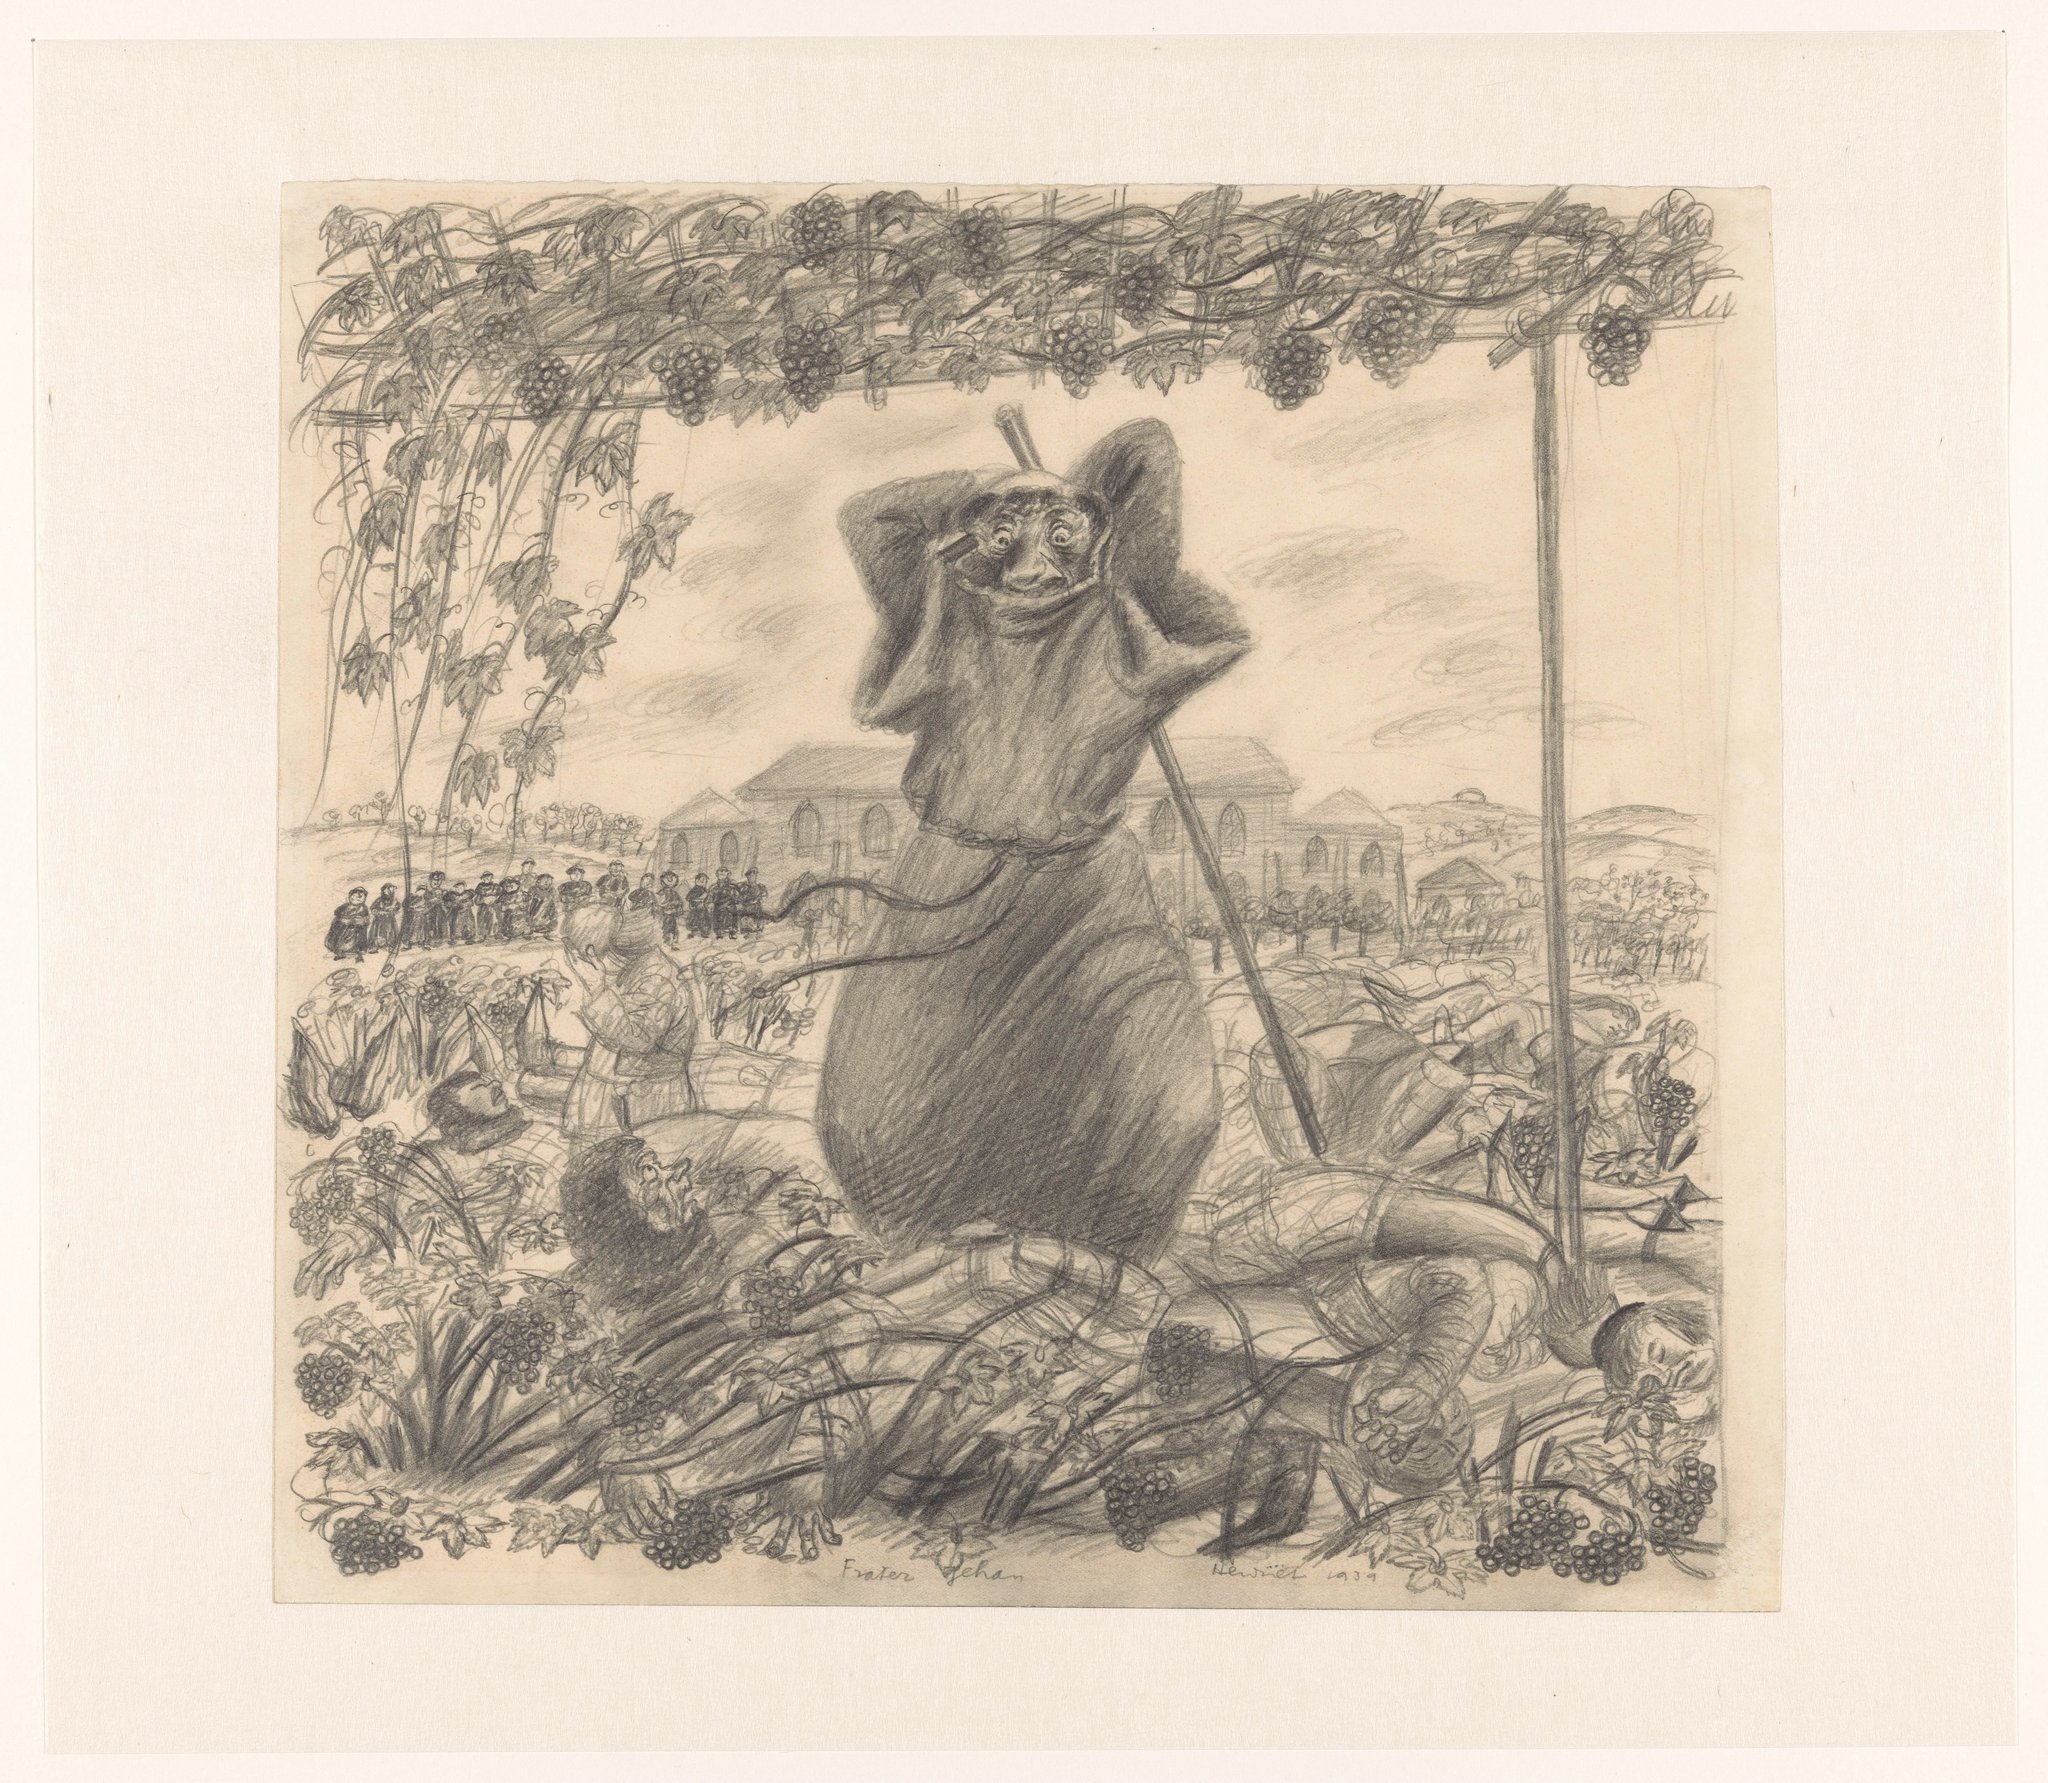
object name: drawing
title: Frater Johan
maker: henk henriët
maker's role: draughtsman, print maker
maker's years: 1903-1945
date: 1939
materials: paper, pencil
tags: vine, abbey, monastery, convent ~ roman catholic church, battle, monk(s), friar(s)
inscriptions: collector's mark: Lugt 2228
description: Monnik in een wijngaard die een stok boven zijn hoofd houdt. Onder hem ligt een wirwar van geharnaste lichamen. Achter hem een klooster en toekijkende monniken.